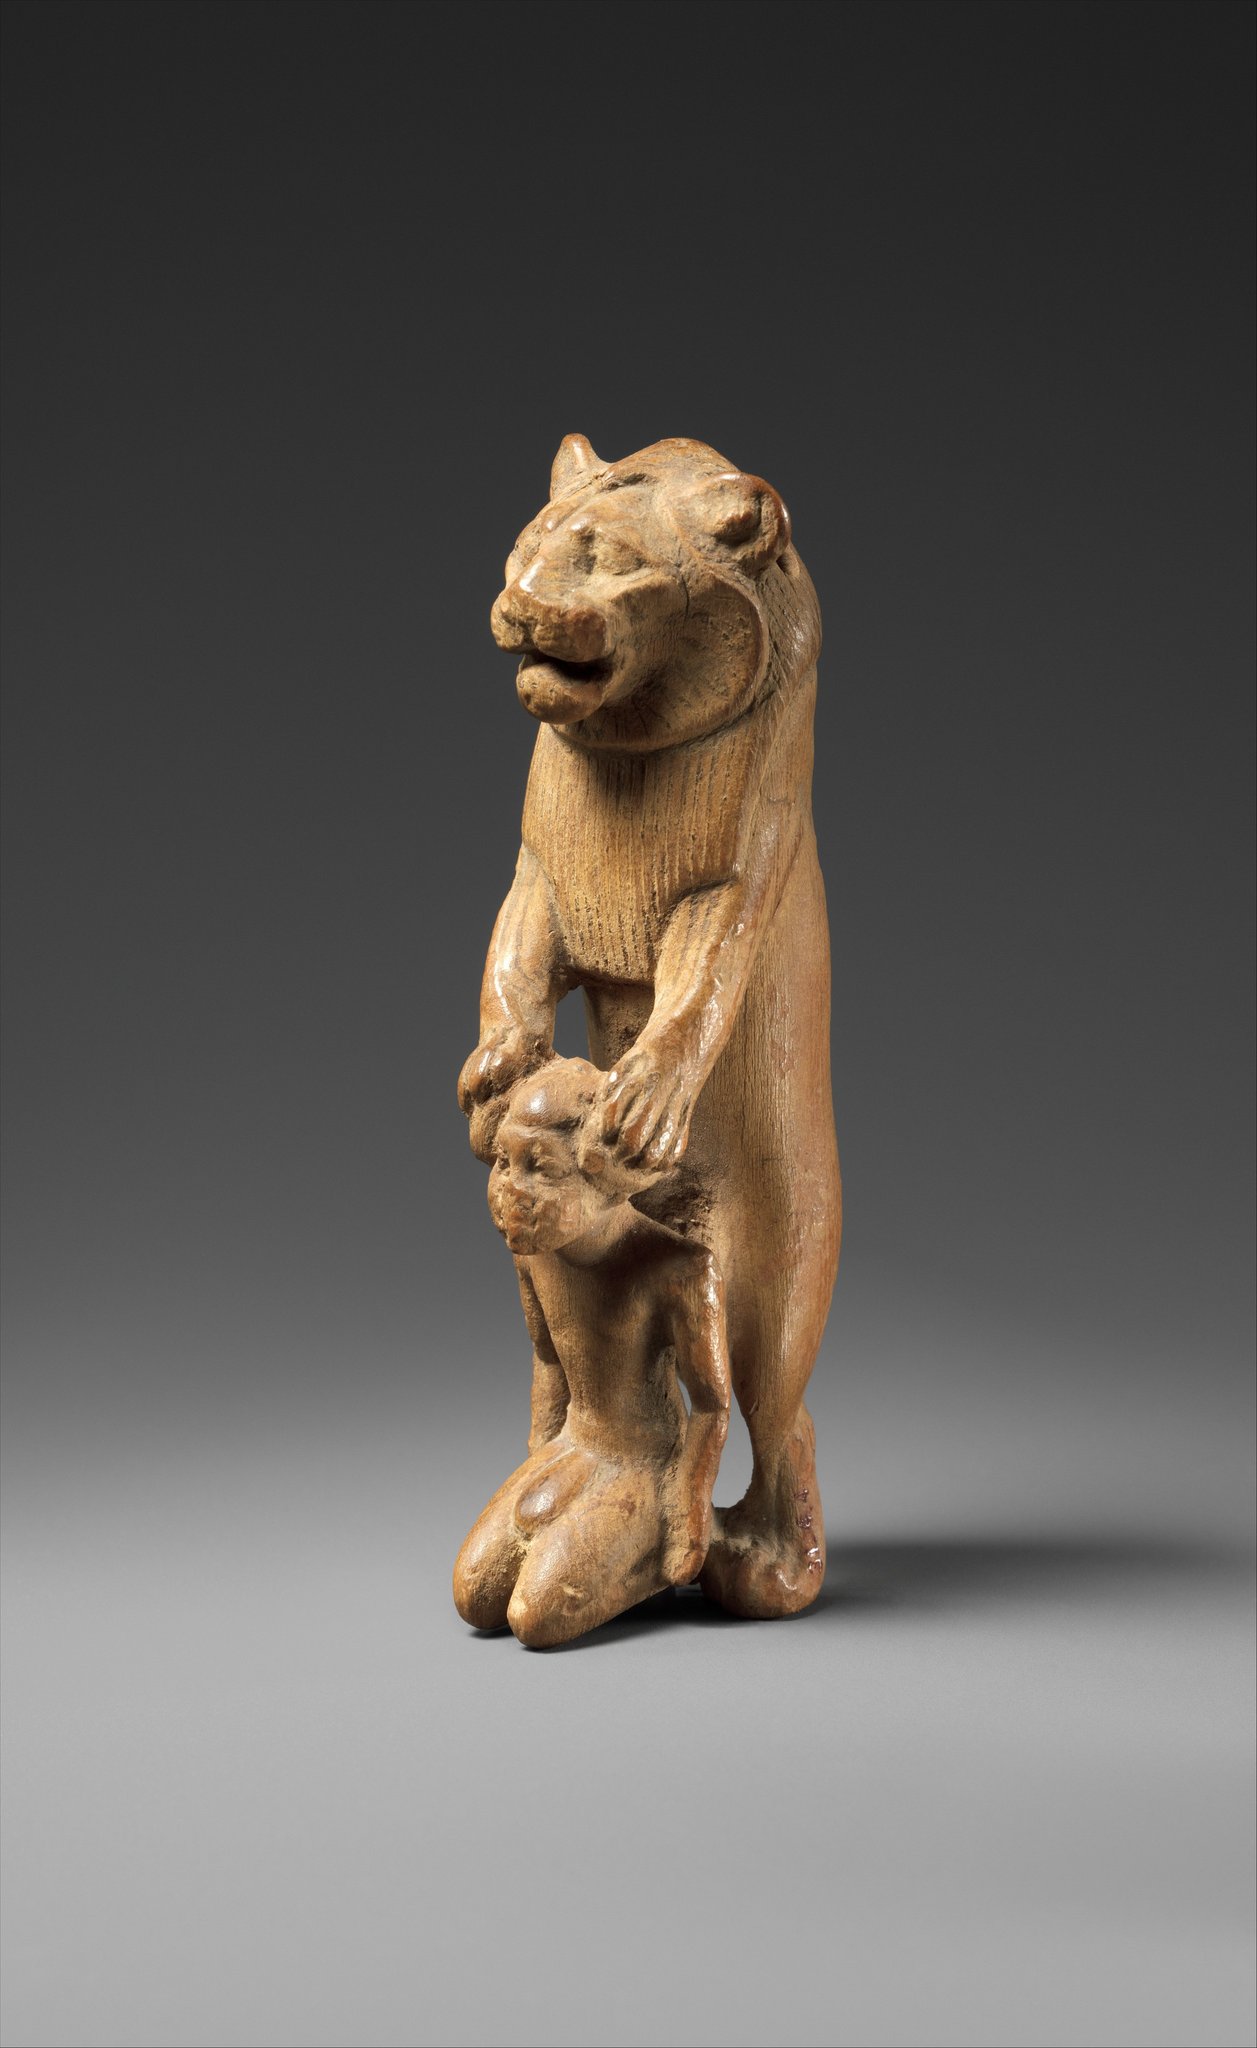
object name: statuette, lion, nubian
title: Statuette of lion holding a Nubian captive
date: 1850-1550 BCE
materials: wood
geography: egypt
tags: boys,lions